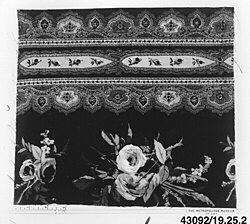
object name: sample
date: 1830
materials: wool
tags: flowers